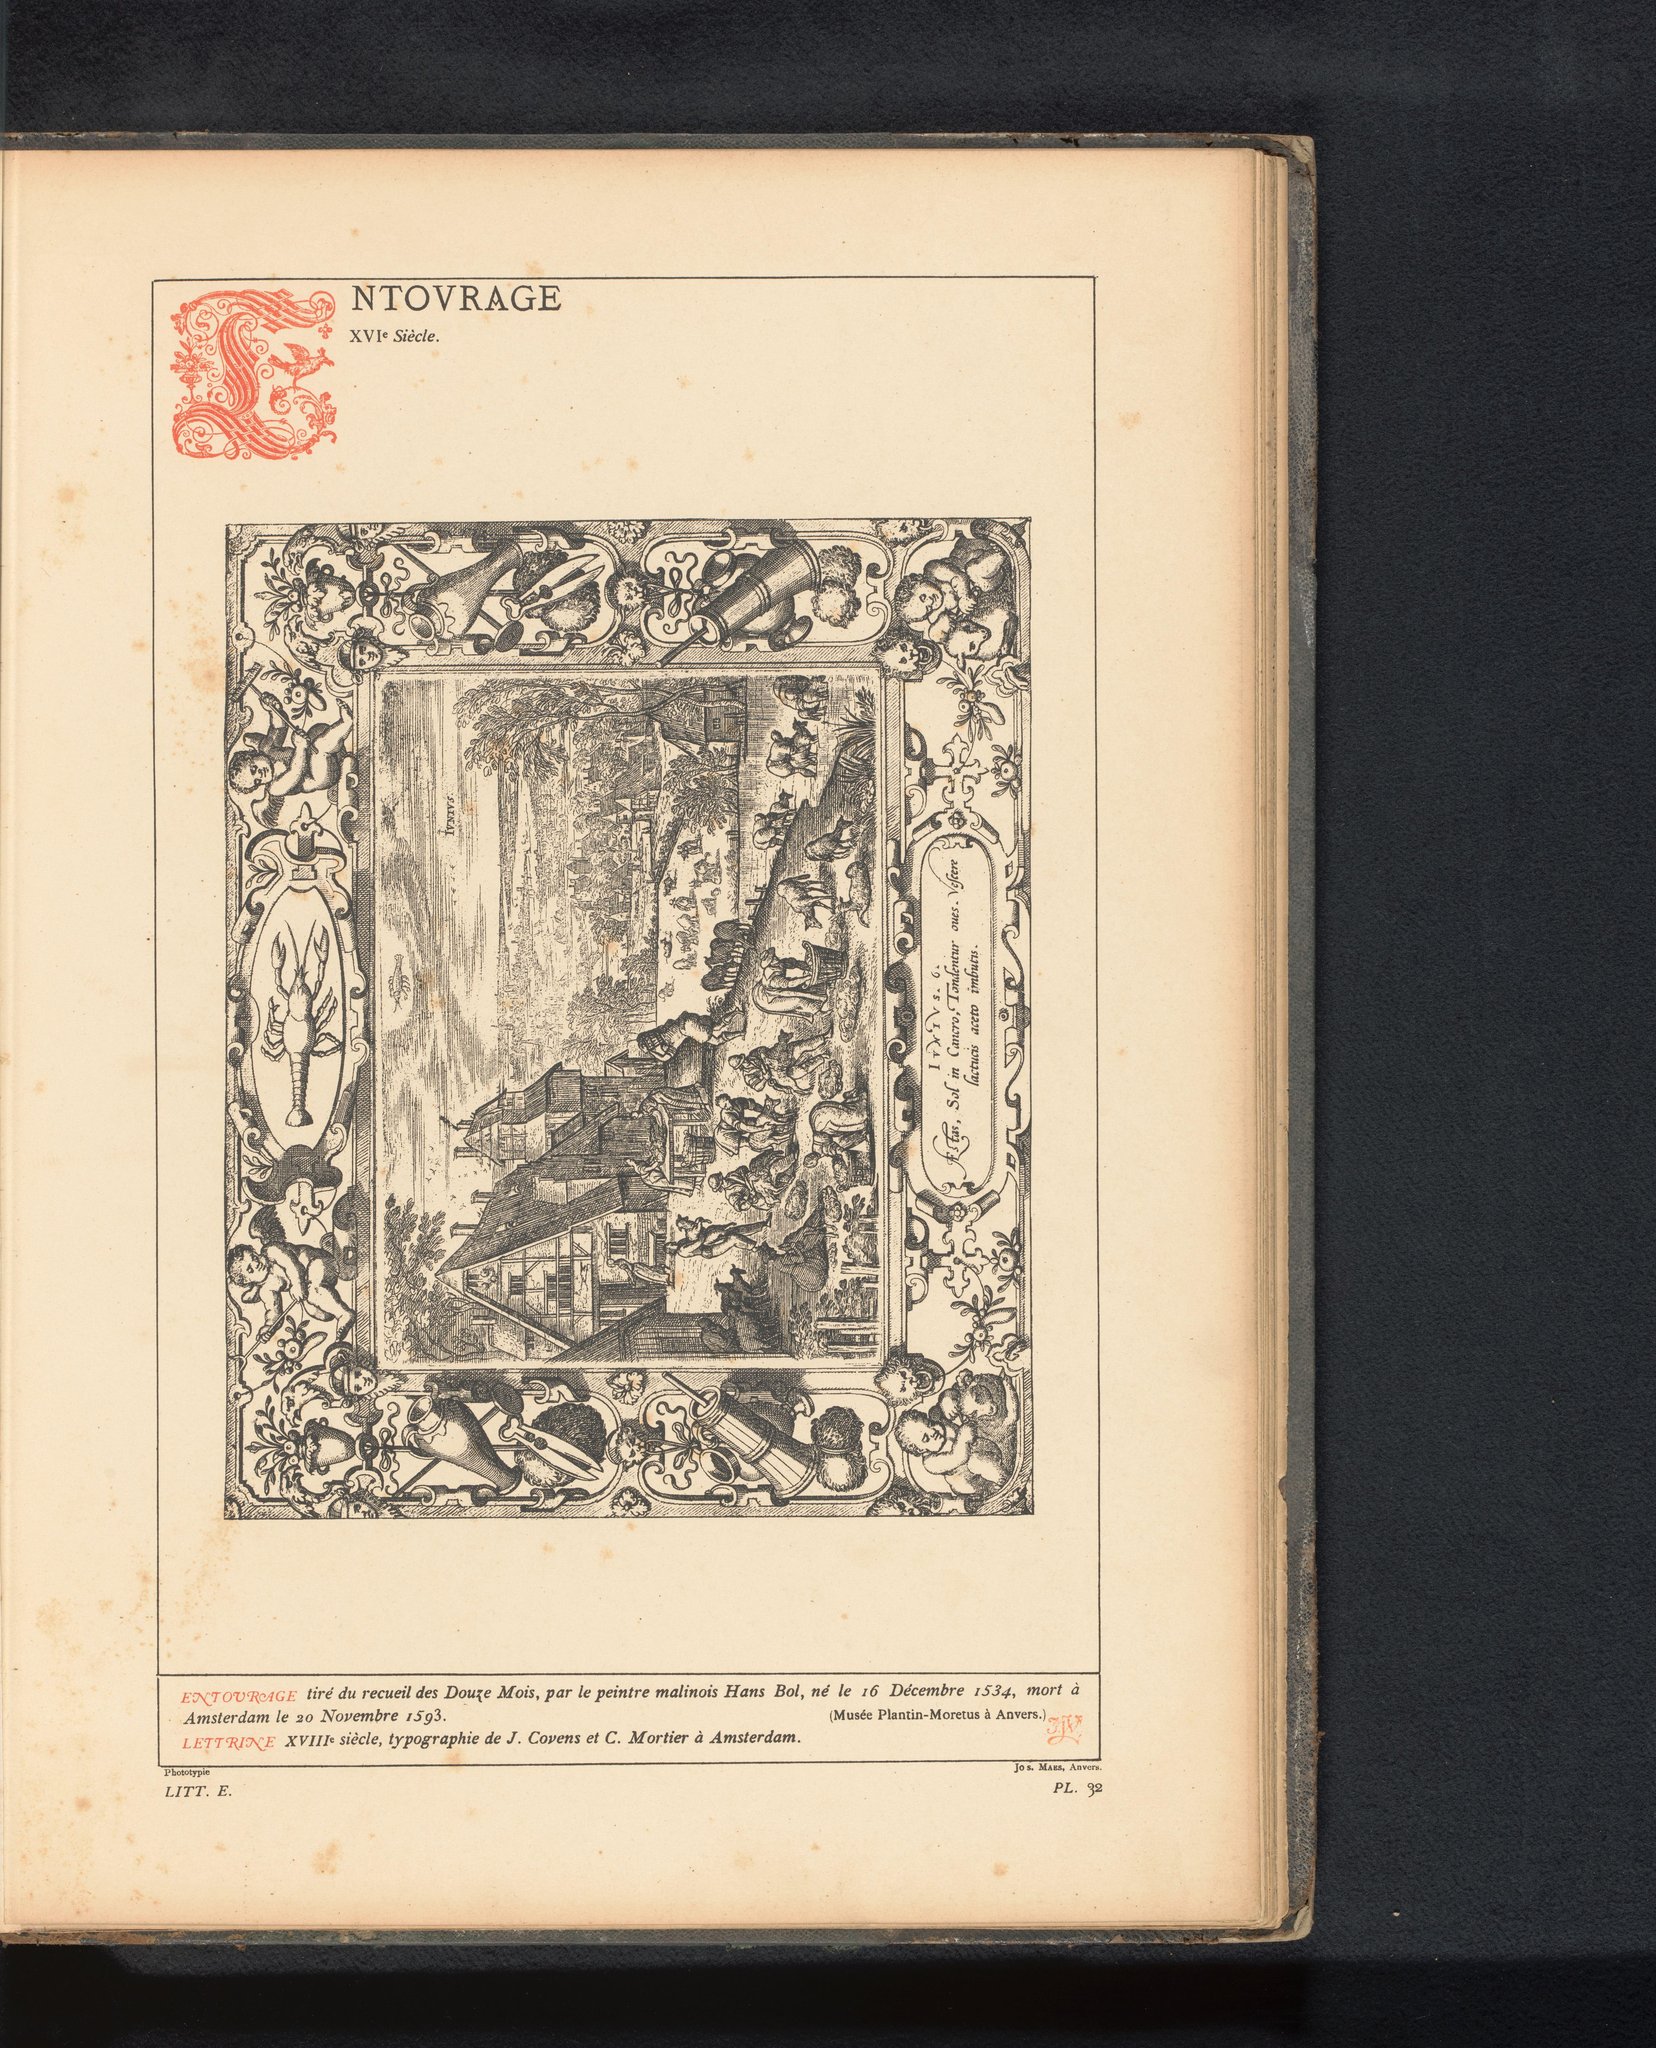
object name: page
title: Reproductie van een prent van Juni uit de serie Twaalf Maanden naar Hans Bol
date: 1875-1880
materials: paper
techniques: photolithography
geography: amsterdam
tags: ornament ~ grotesque, june and its 'labours'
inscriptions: monogram: ‘JJvY’, inscription: ‘ENTOURAGE tiré du (...)’, inscription: ‘LITT. E. - PL. 32’